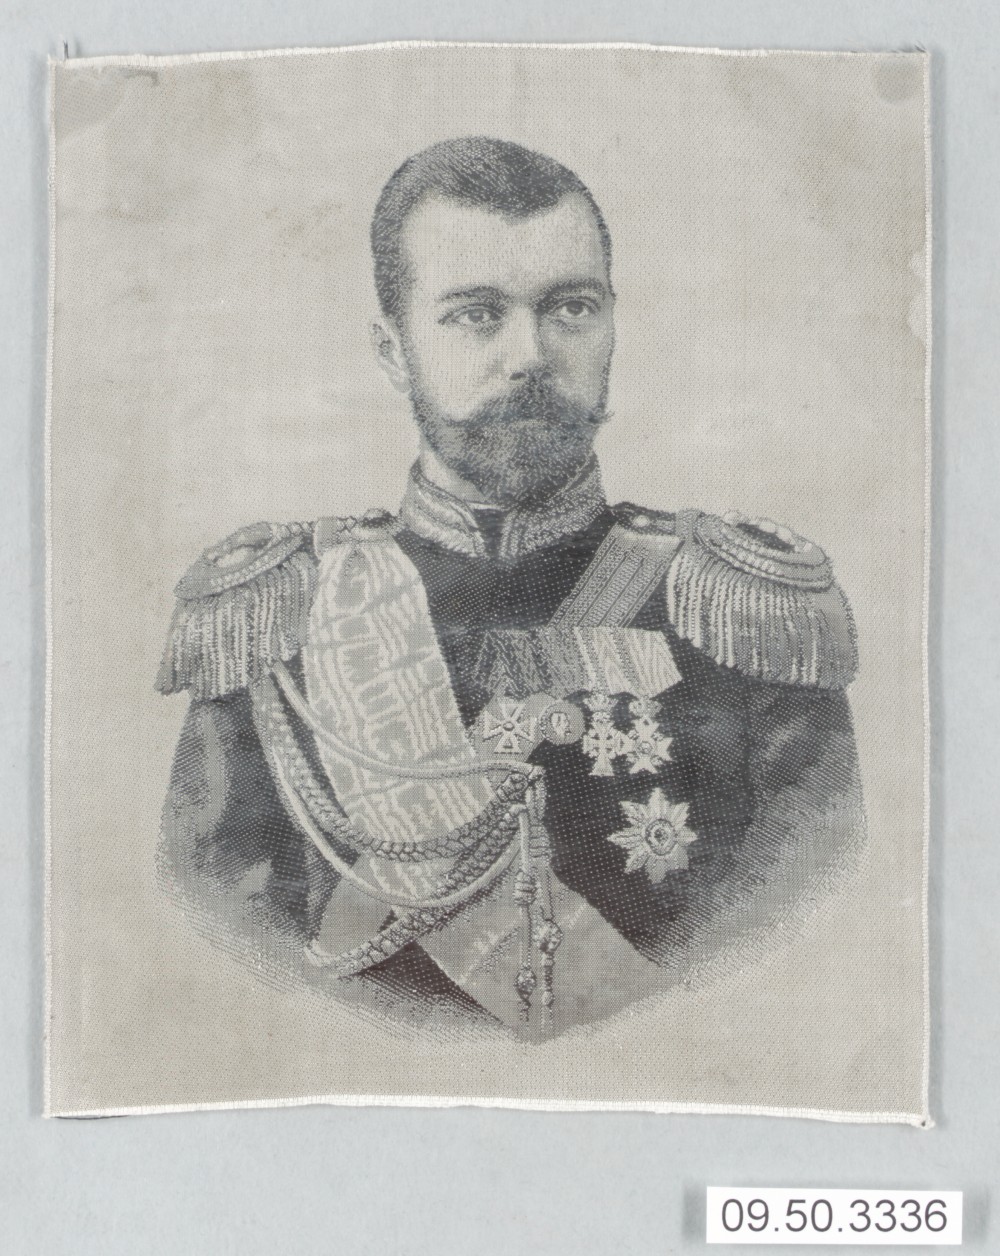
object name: portrait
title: Nicholas II, Czar of Russia (1868–1917)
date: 1867-1900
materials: silk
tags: men,portraits